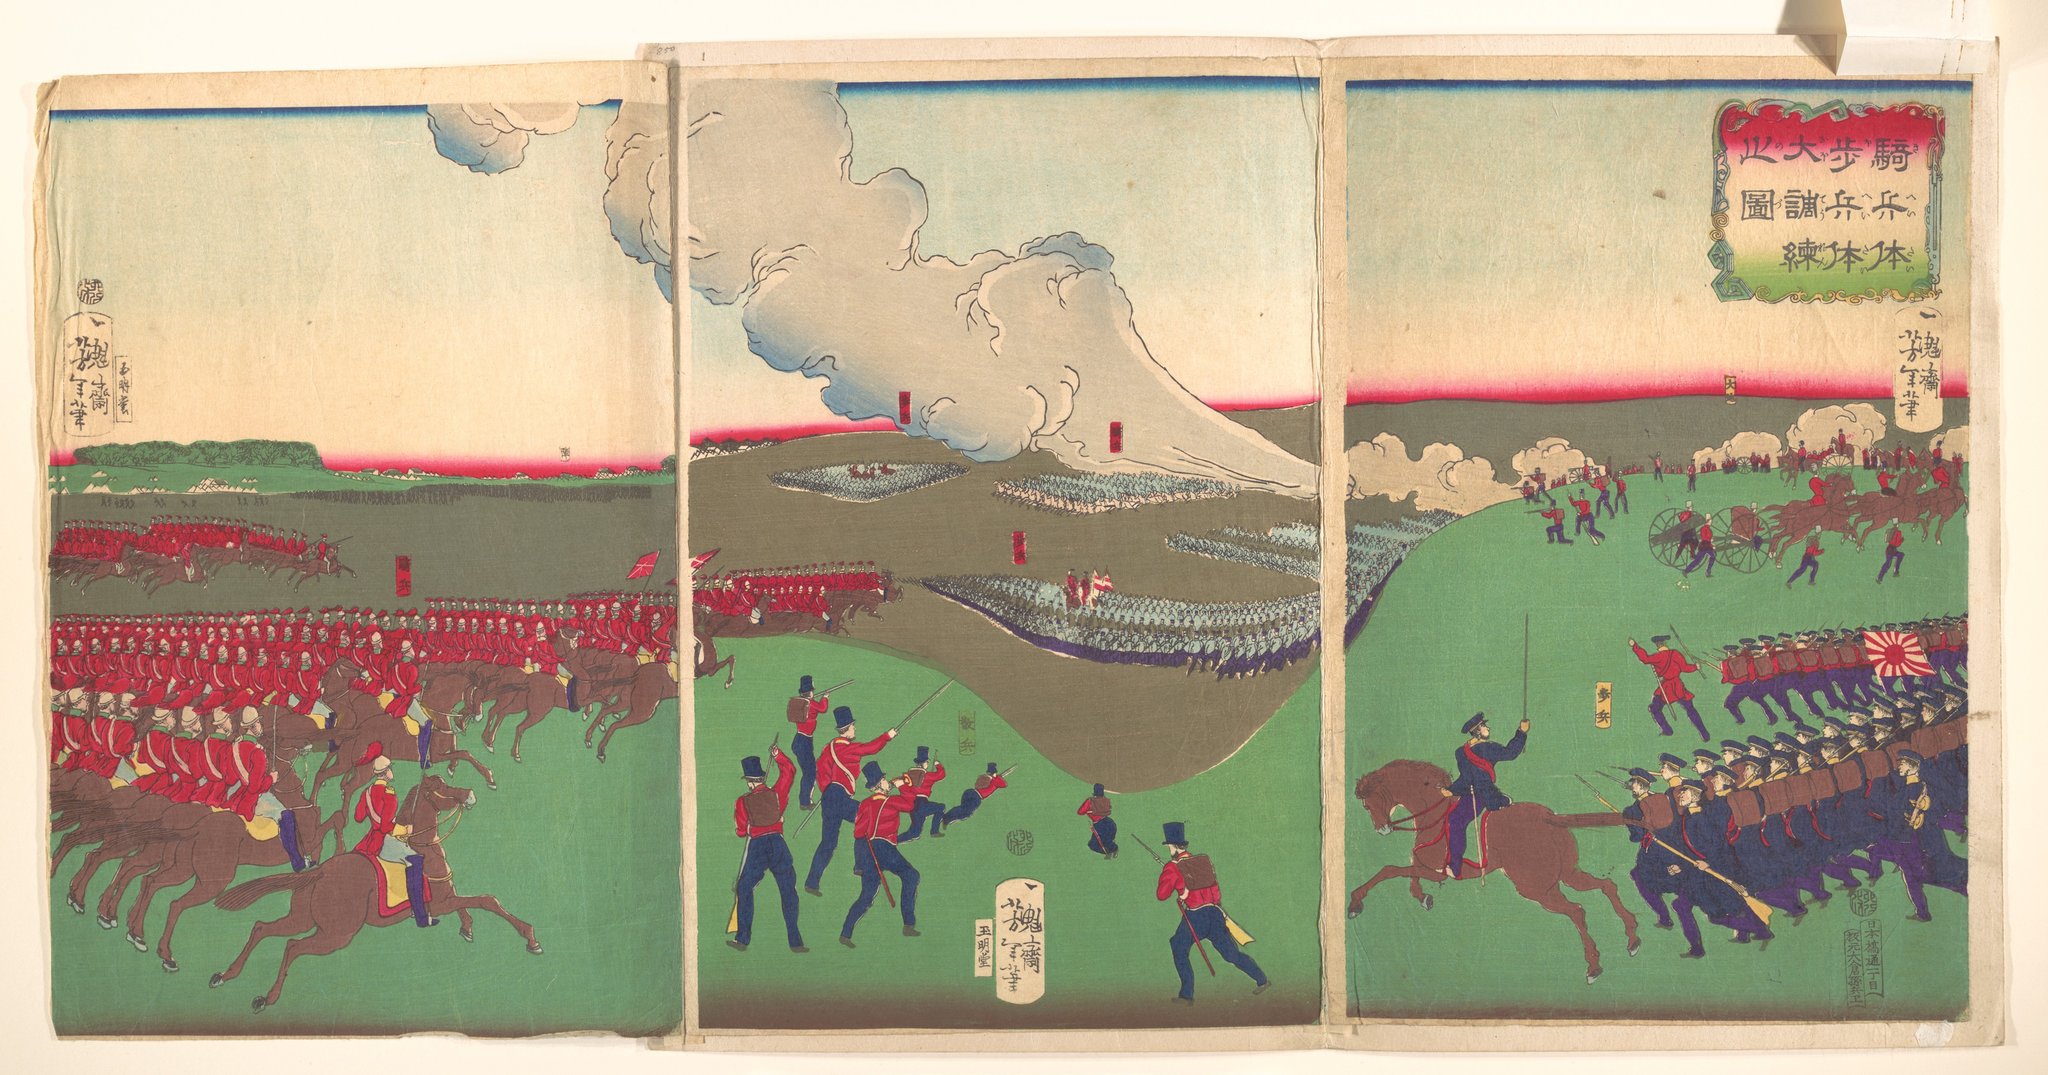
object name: print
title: Illustration of Cavalry, Infantry and Soldiers Retreating (Kiheitai, hoheitai, daichōren no zu)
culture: japanese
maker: tsukioka yoshitoshi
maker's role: artist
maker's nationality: japanese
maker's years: 1839-1892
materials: ink, paper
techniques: woodblock print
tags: battles,soldiers,horses